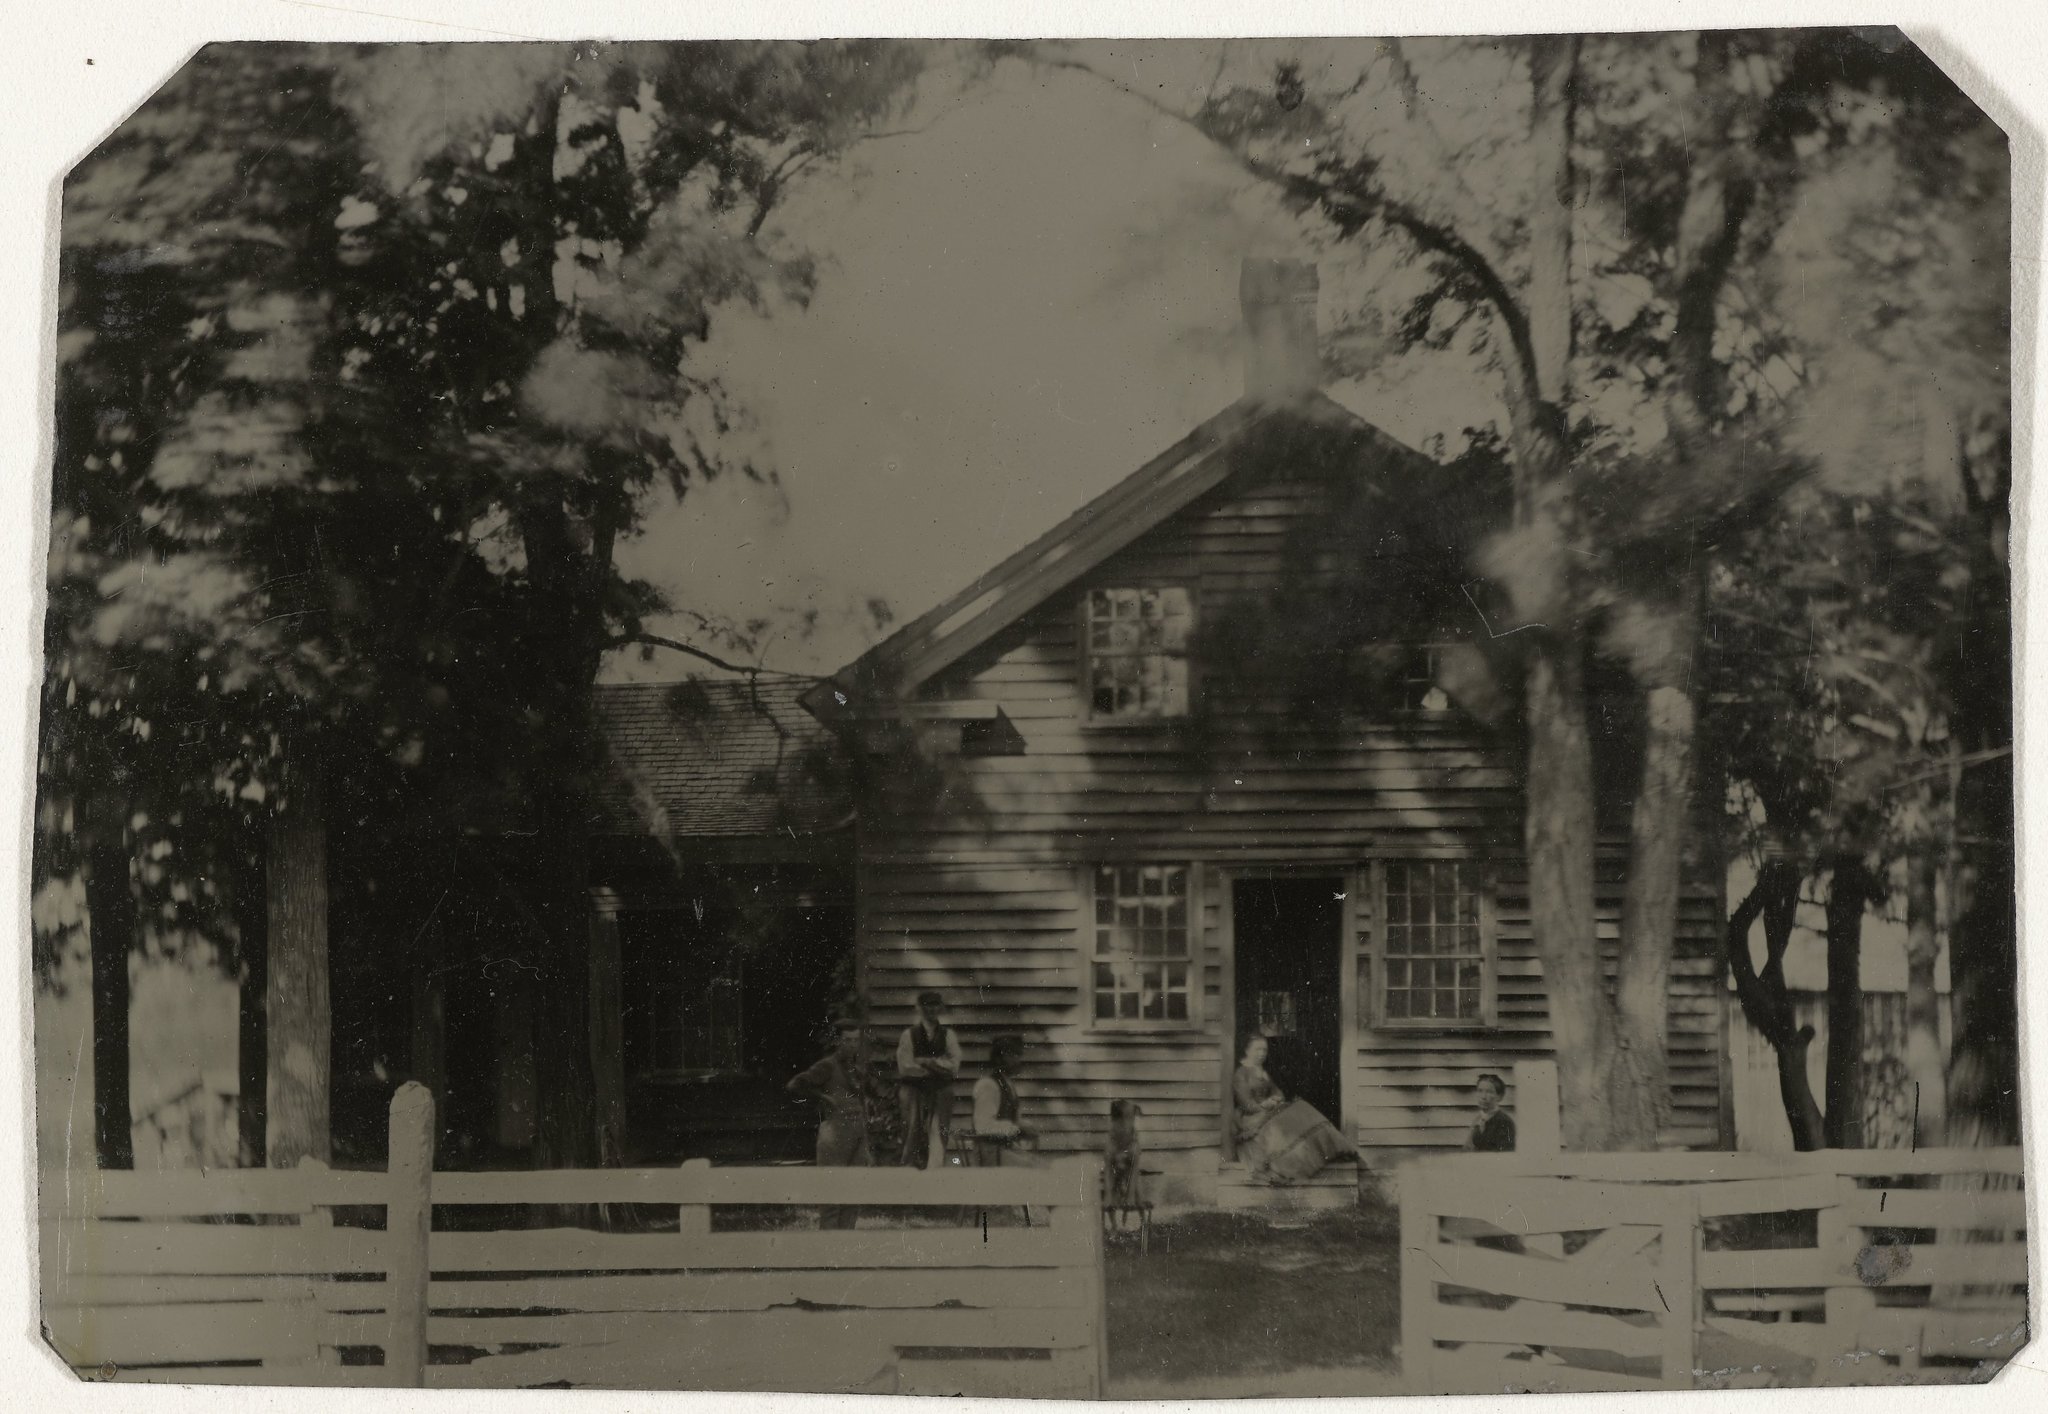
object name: photograph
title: Gezicht op een houten huis, met vijf personen en een hond (?) ervoor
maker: Anonymous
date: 1870-1900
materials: metal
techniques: ferrotyping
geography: united states